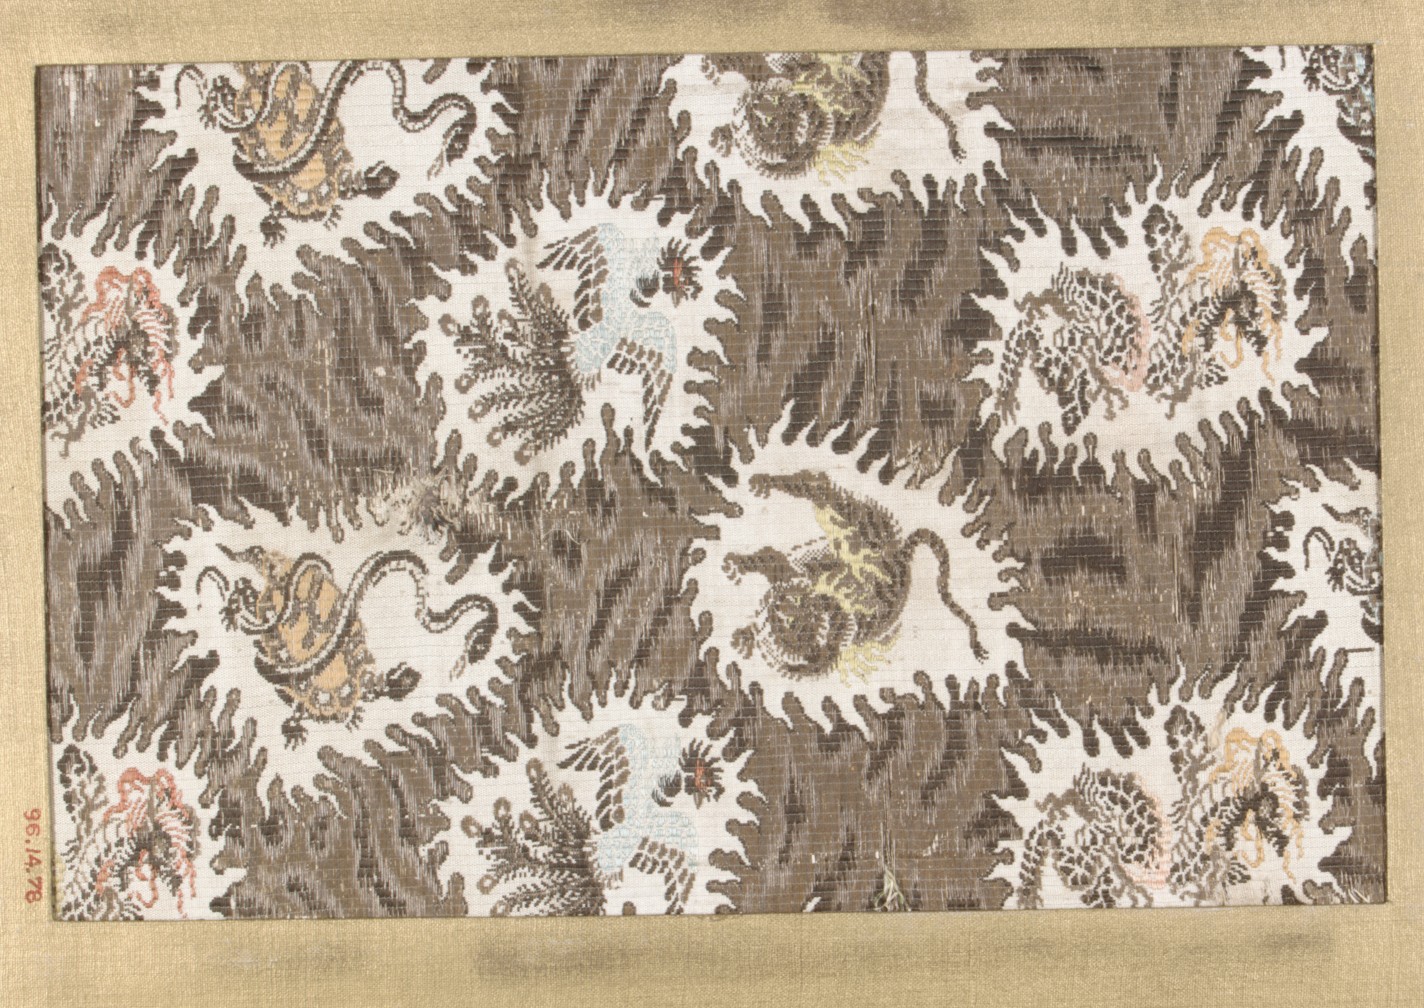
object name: piece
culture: japanese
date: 1701-1900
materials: silk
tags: mythical creatures,snakes